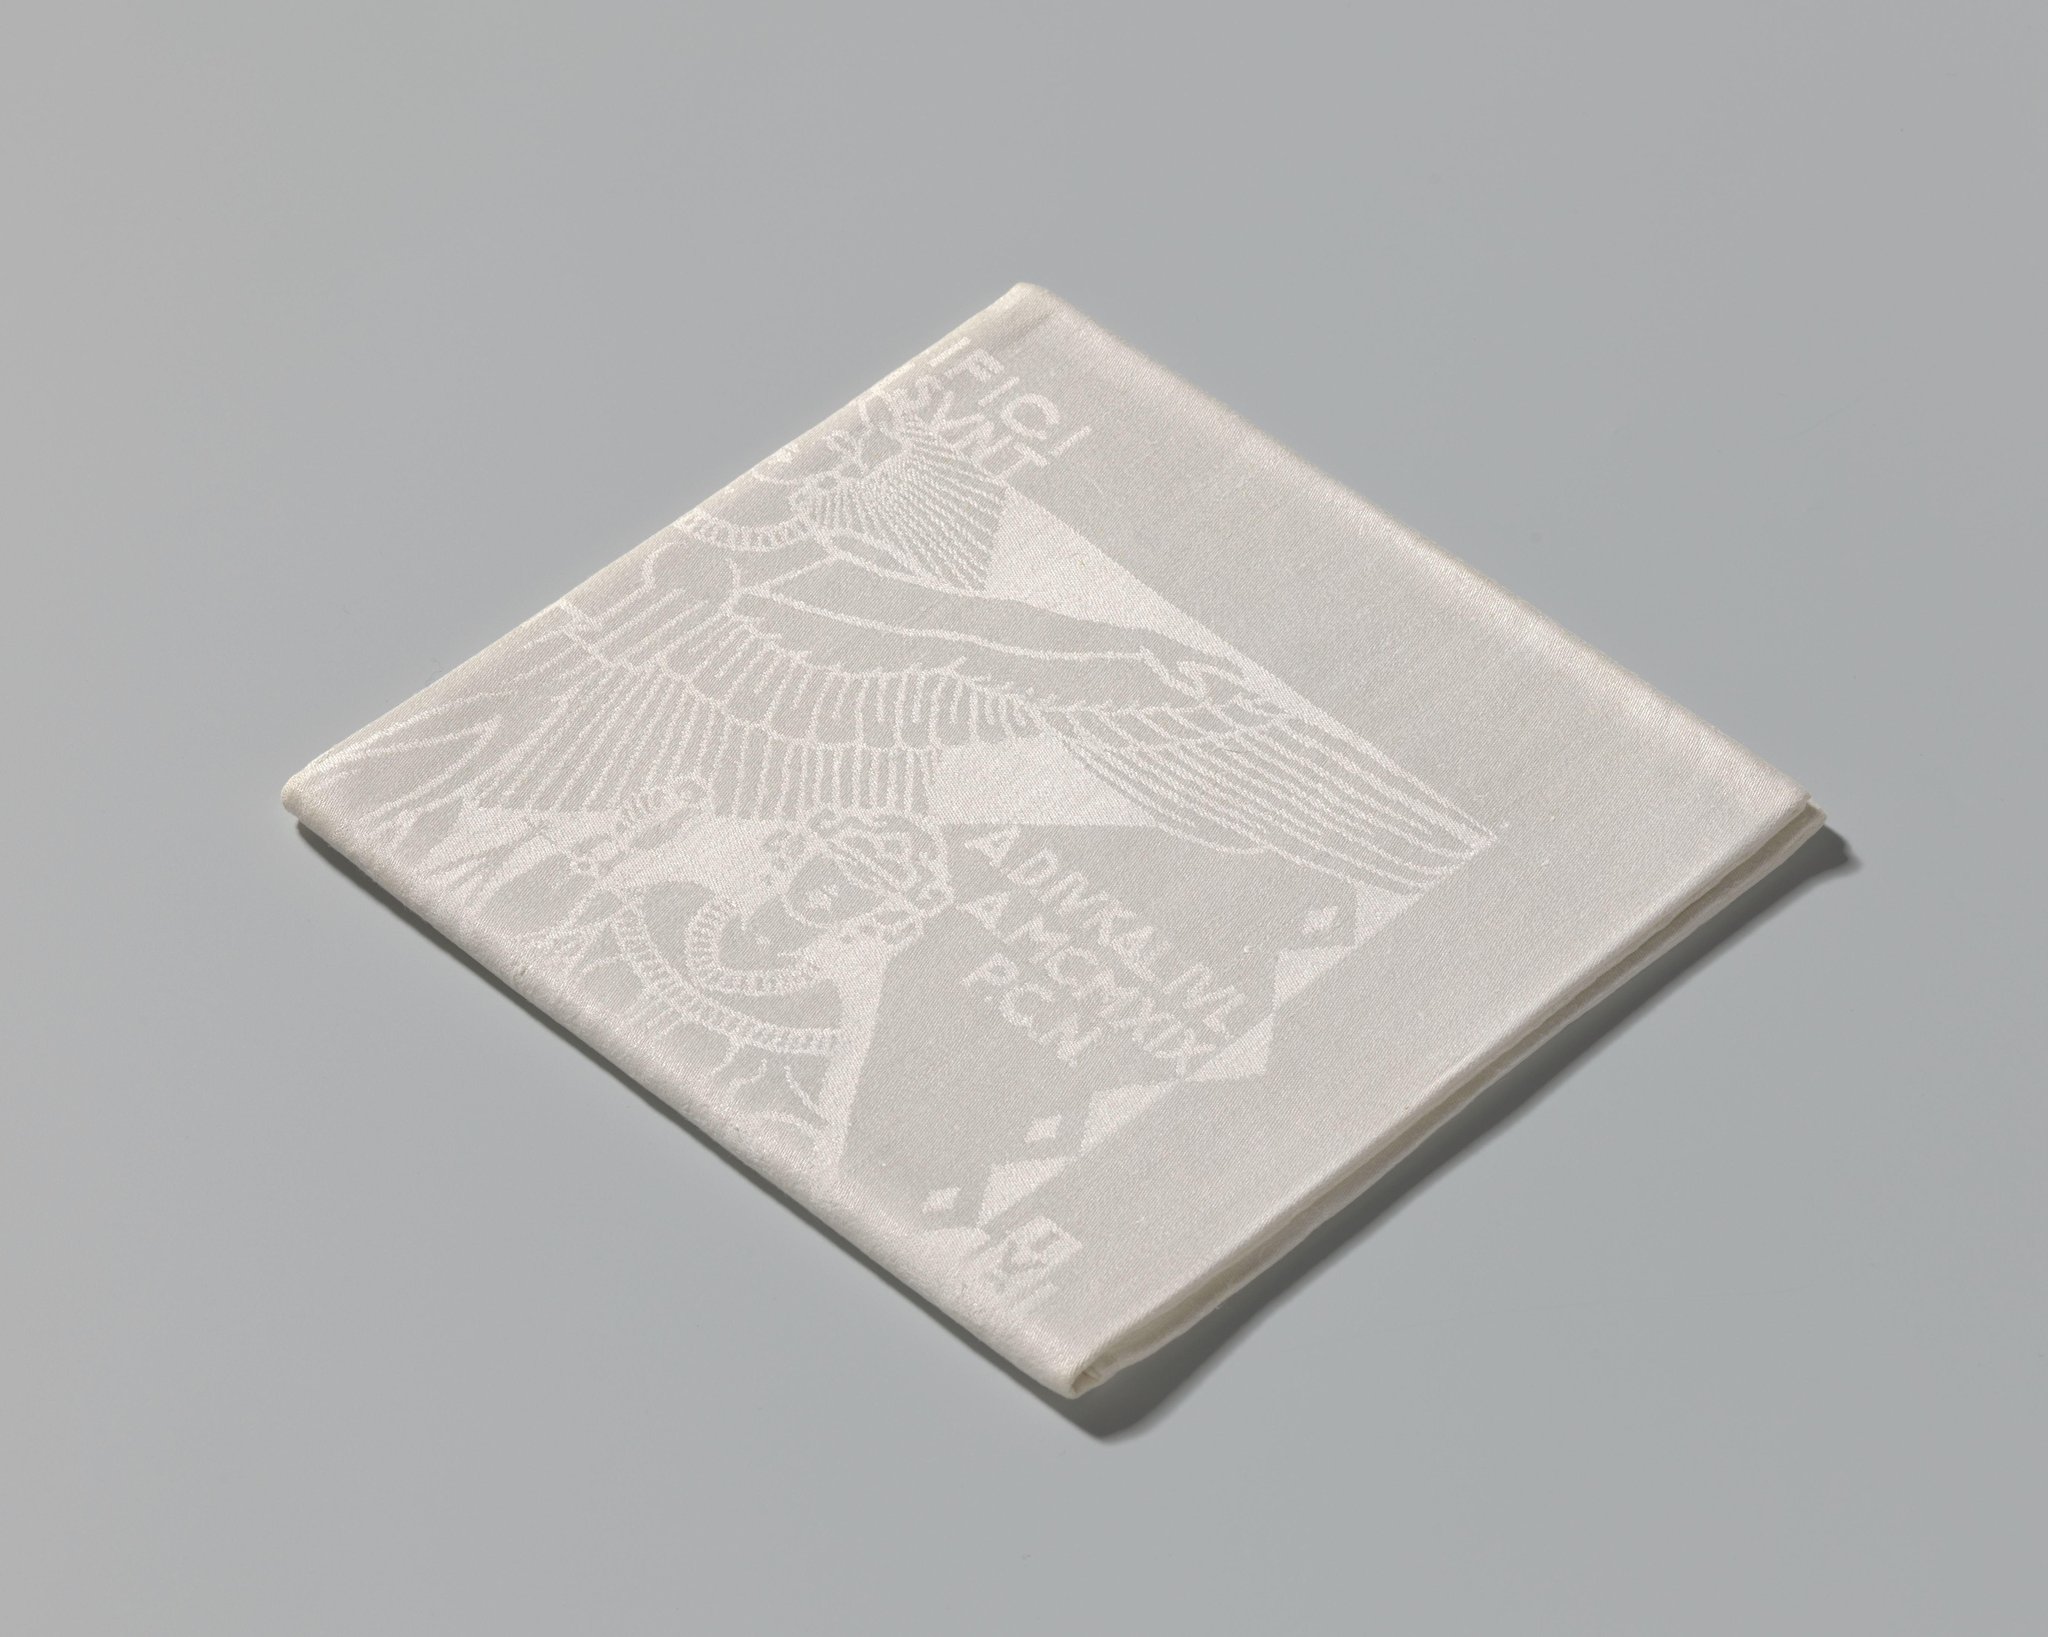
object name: napkin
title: Servet van wit linnendamast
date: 1919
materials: linen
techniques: damask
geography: netherlands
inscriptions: number: ‘558’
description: Wit linnen damasten servet met de Vrede van Versailles.